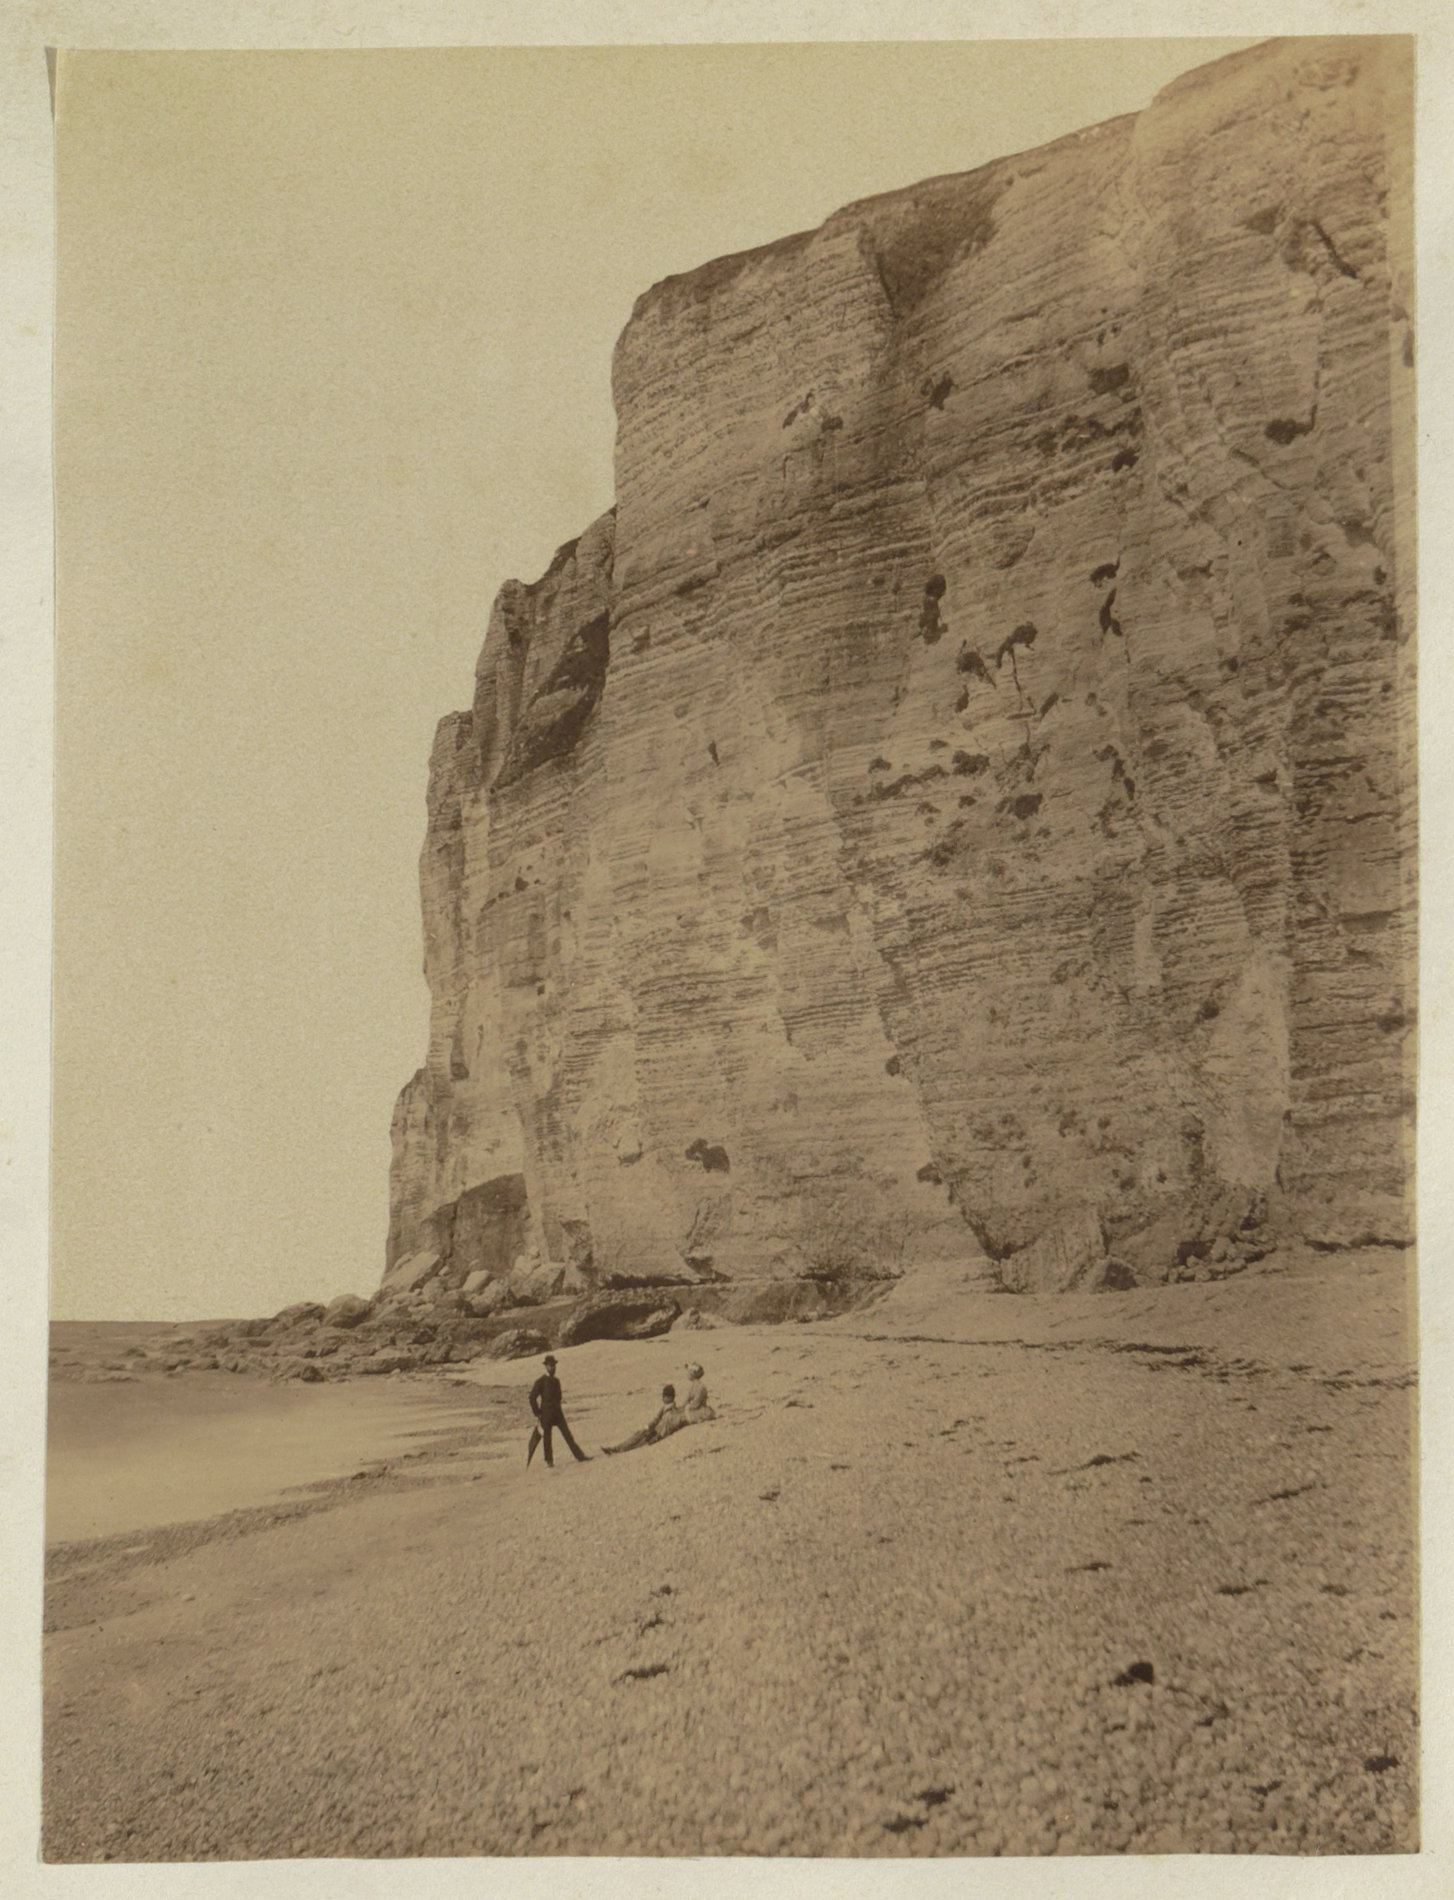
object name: photograph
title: Gezelschap op een strand voor een rotswand, vermoedelijk bij Etretat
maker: Anonymous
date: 1808-1883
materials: photographic support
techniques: albumen print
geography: etretat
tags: beach (as place of recreation), coastal cliff or crag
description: Onderdeel van Album van een Franse amateurfotograaf met opnames van familie, militairen, industrie, landschappen en bezienswaardigheden in Frankrijk.